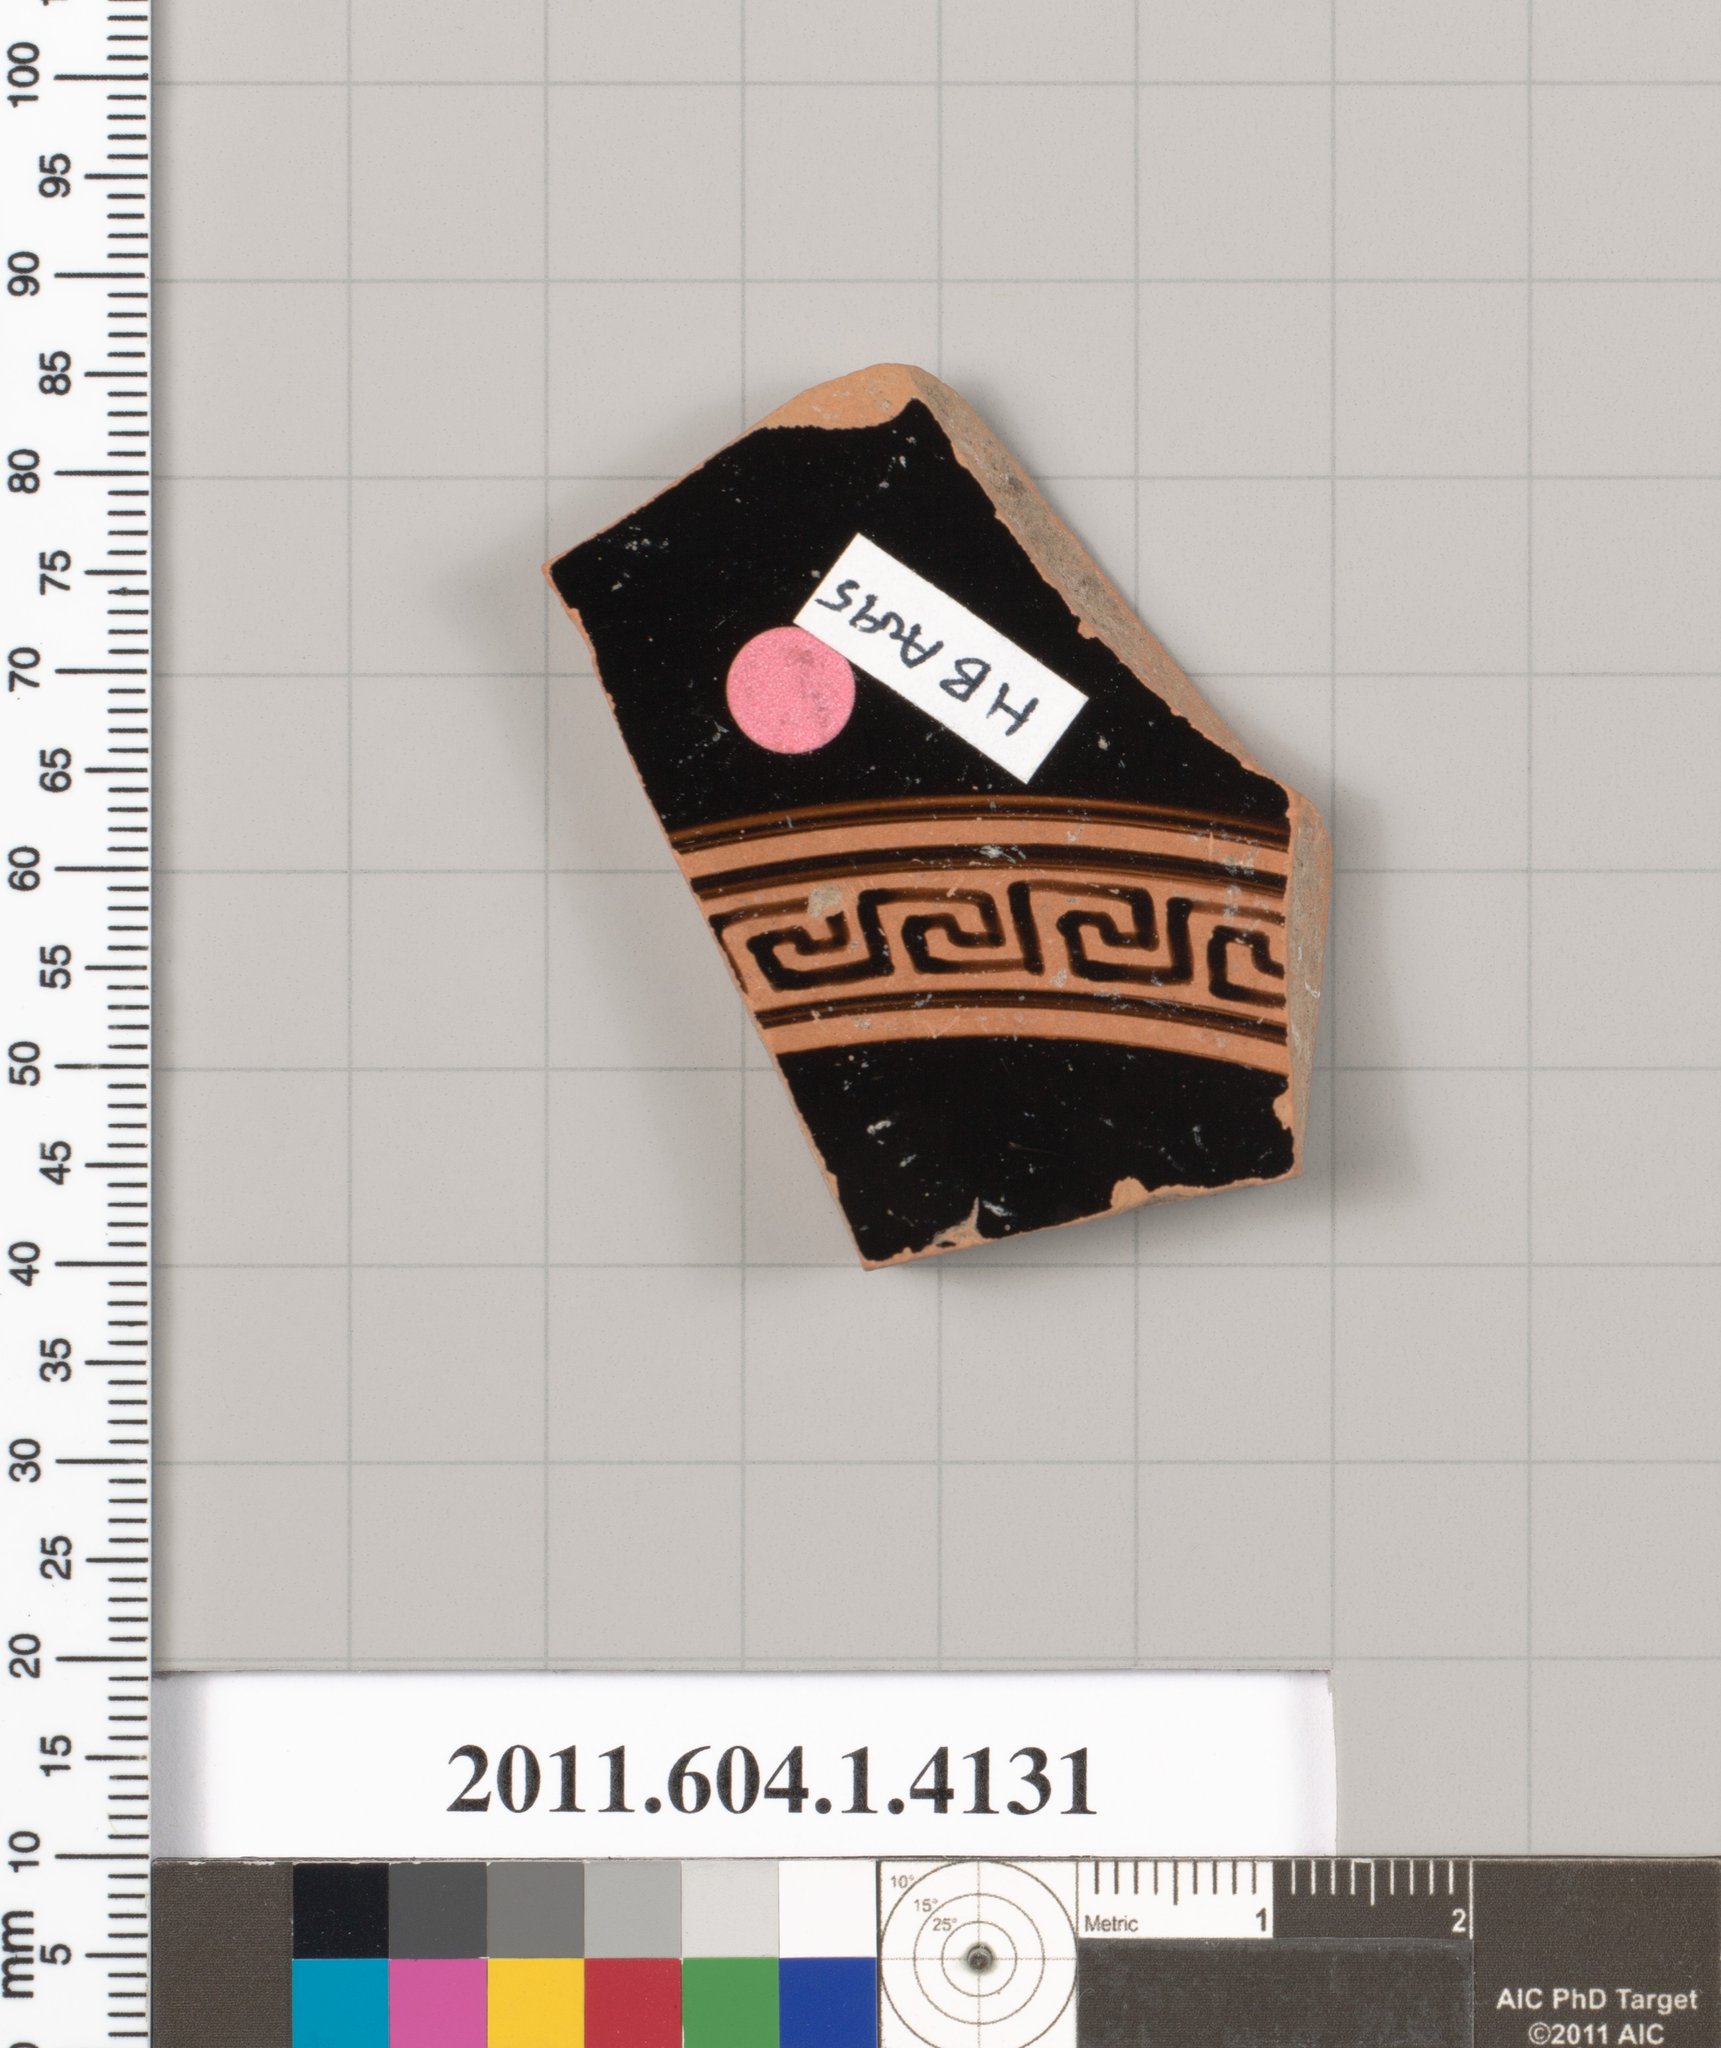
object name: kylix fragment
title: Terracotta fragment of a kylix (drinking cup)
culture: greek, attic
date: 500-480 BCE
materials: terracotta